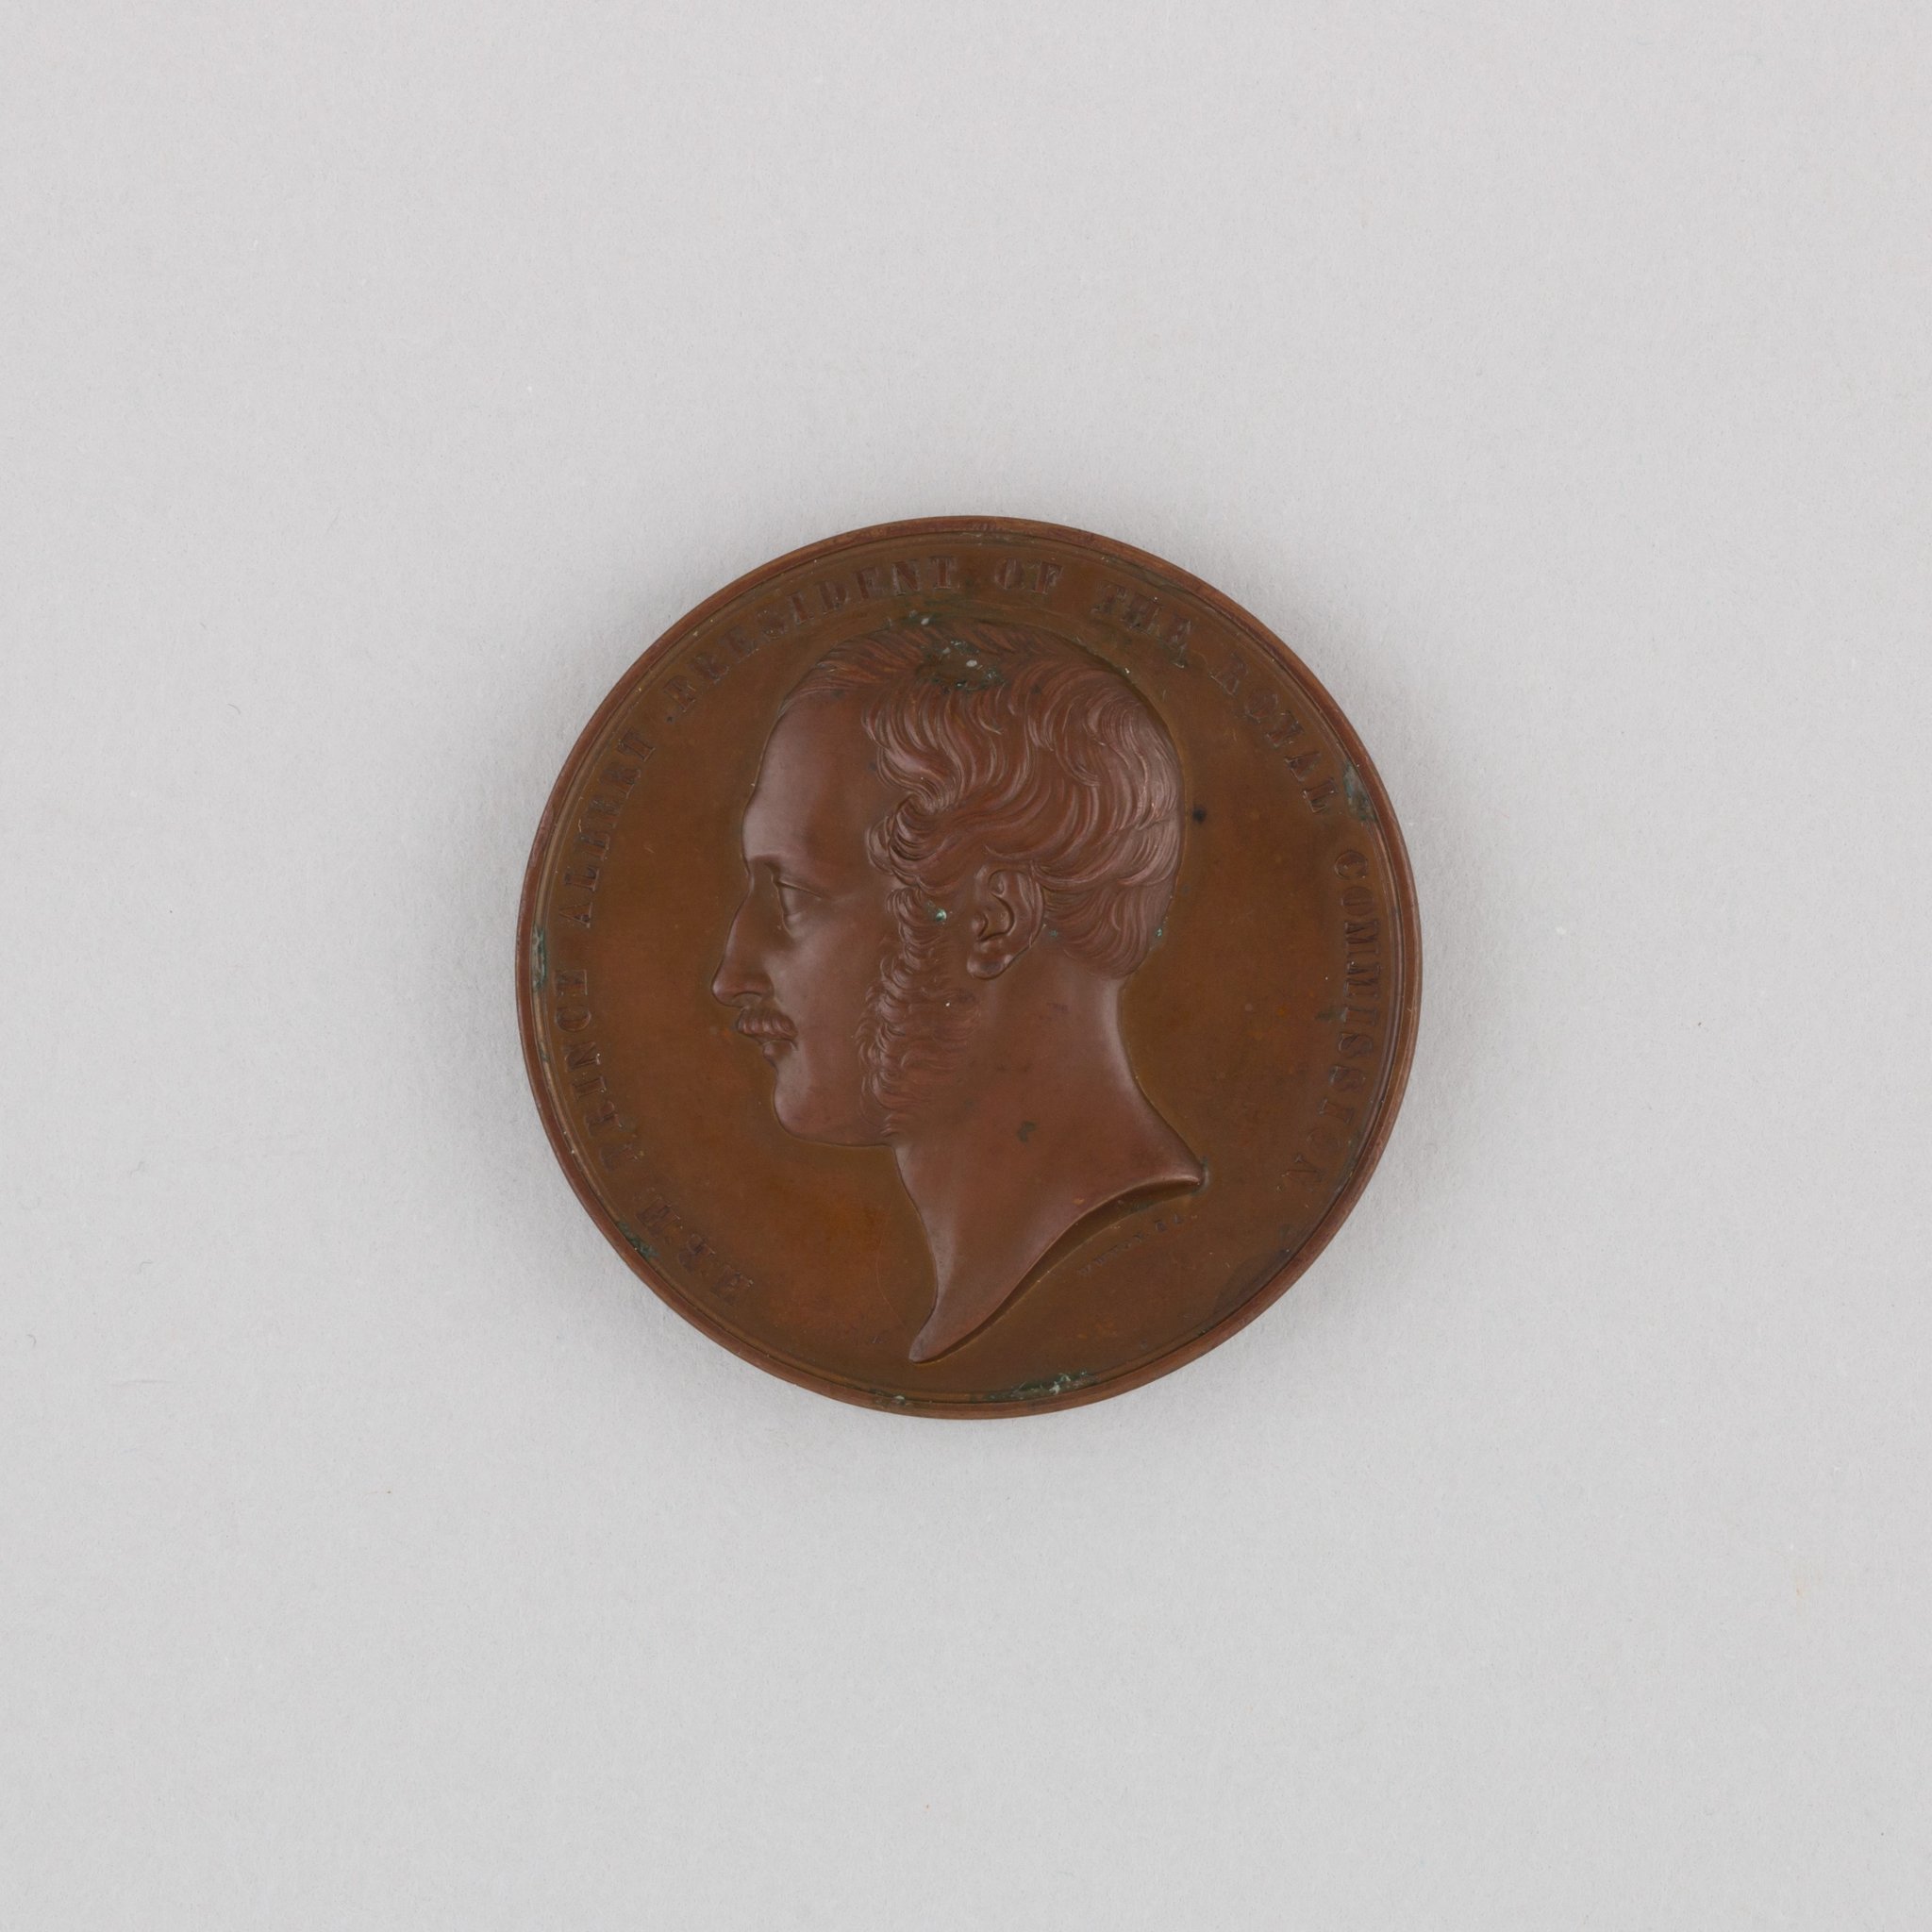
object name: medal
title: Medal Awarded to the Sword Makers Robert Mole and Sons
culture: british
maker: william wyon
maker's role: artist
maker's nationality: british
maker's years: 1795-1851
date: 1851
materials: bronze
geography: england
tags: men,profiles